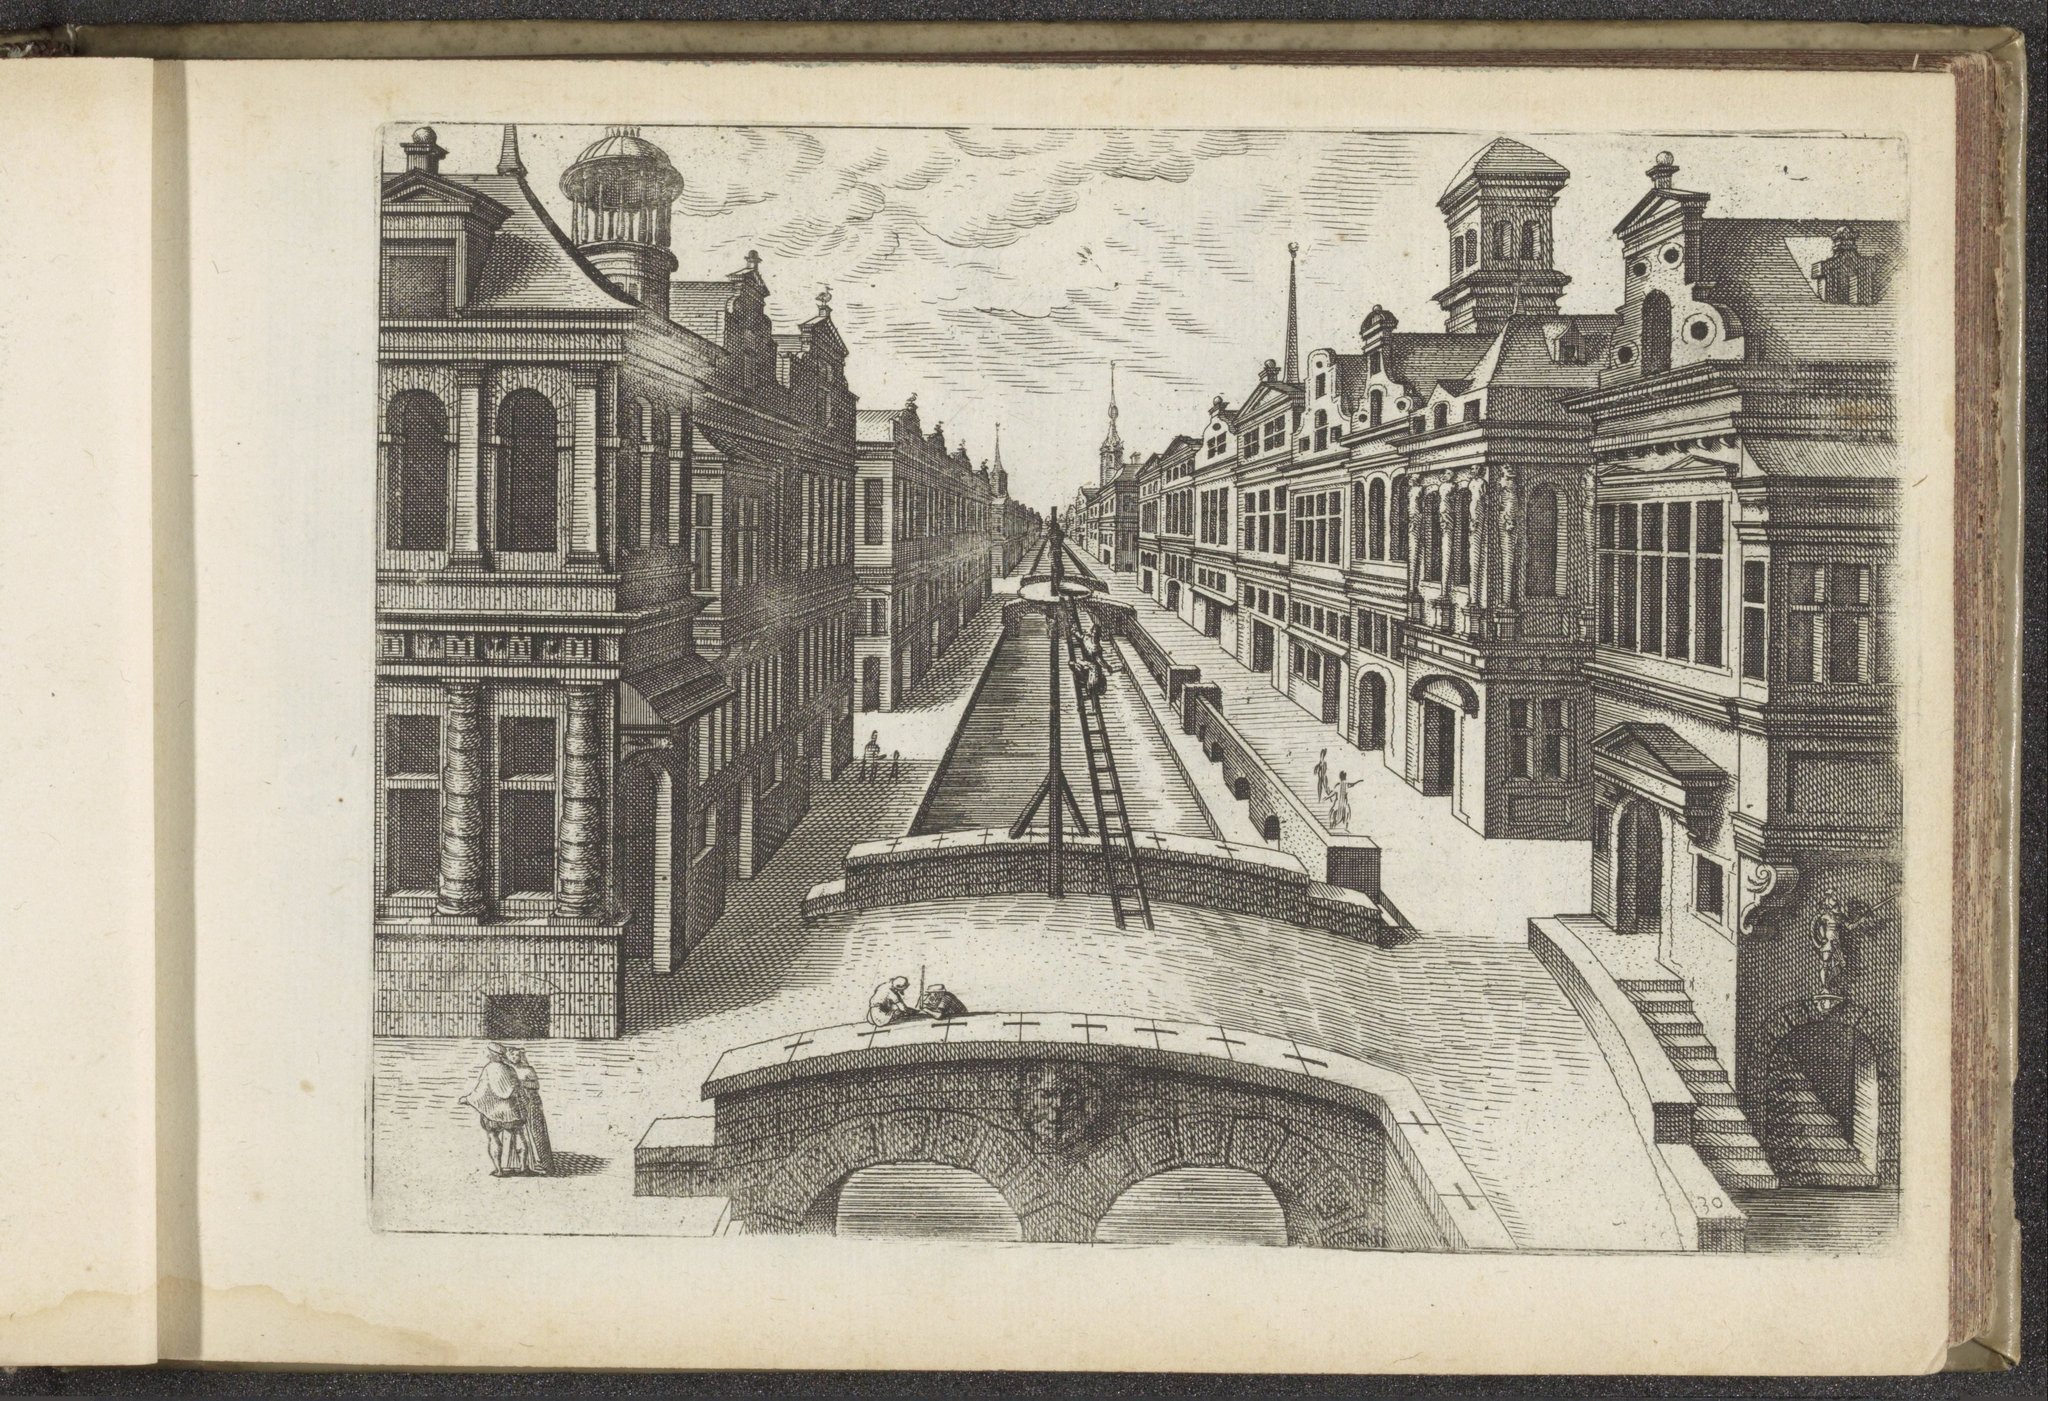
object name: album leaf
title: Variae Architecturae formae (...)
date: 1562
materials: paper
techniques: etching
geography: antwerp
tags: architectural representations in general, canal, street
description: Gezicht op een kanaal of gracht met huizen aan weerszijden. Op de brug een man op een ladder. Deze prent maakt deel uit van een album.